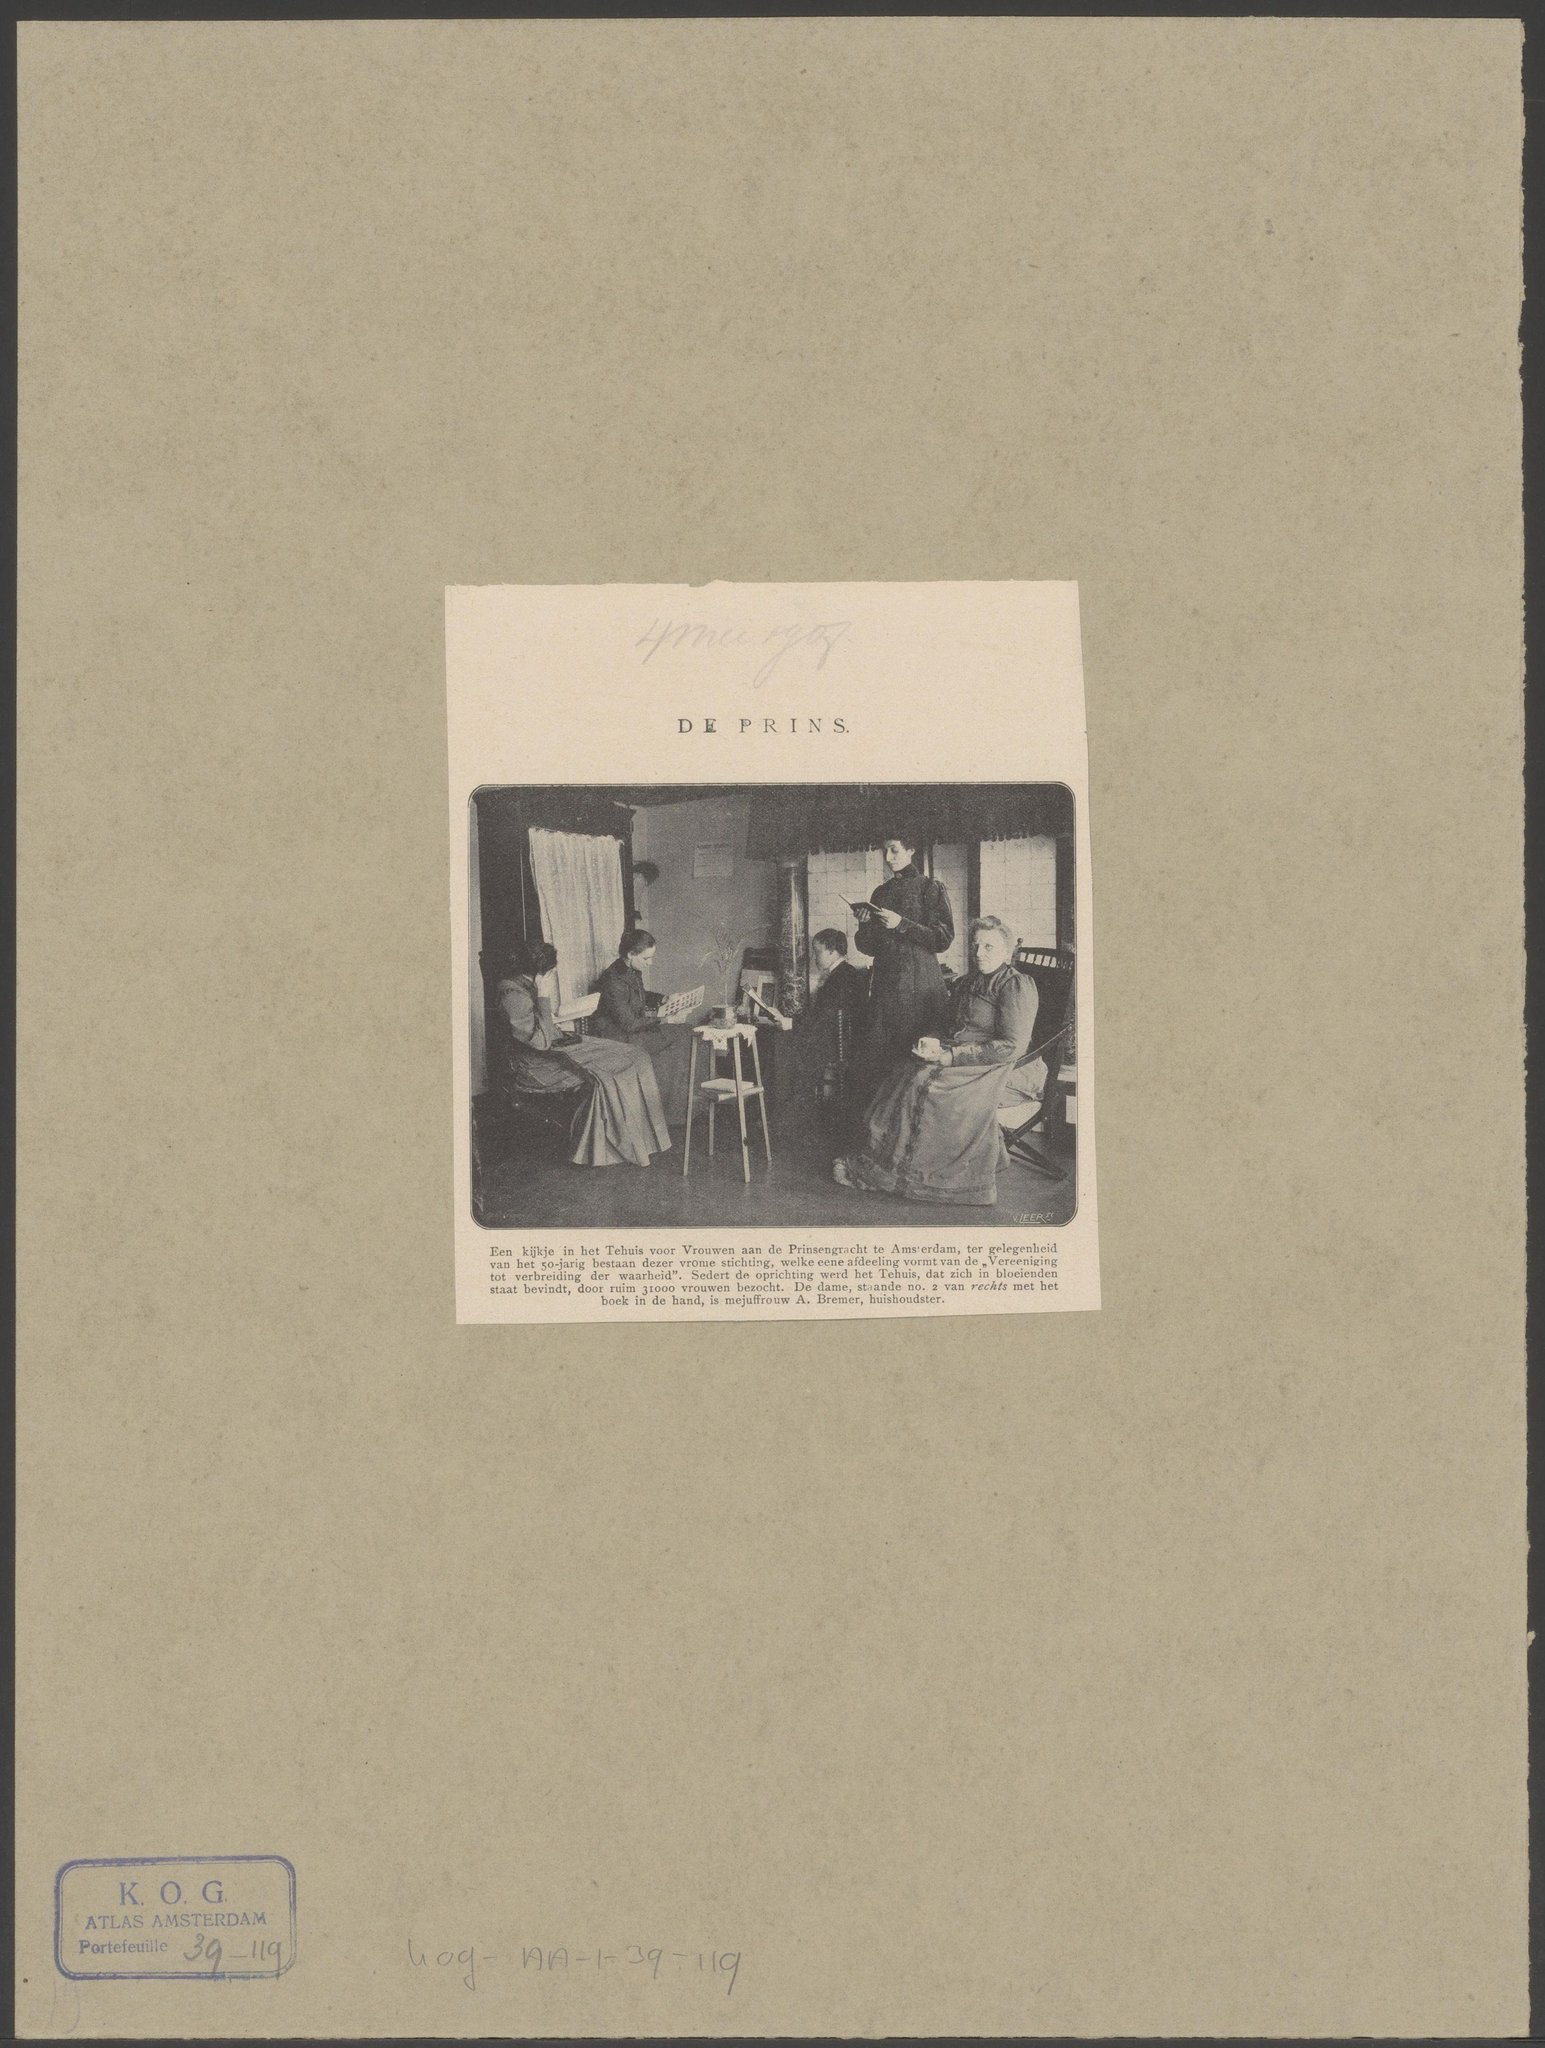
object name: photomechanical print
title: Vrouwen in vrouwenlogement Te Huis te Amsterdam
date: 1907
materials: paper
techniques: letterpress printing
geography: netherlands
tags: public welfare, reading, interior of the house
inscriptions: collector's mark: Lugt 1641b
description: Onderwerpsrubriek binnen de Atlas Amsterdam: Armwezen en liefdadige instellingen: III. Verschillende gestichten en instellingen / Hofjes: Vereeniging ter Verbreiding van de Waarheid.